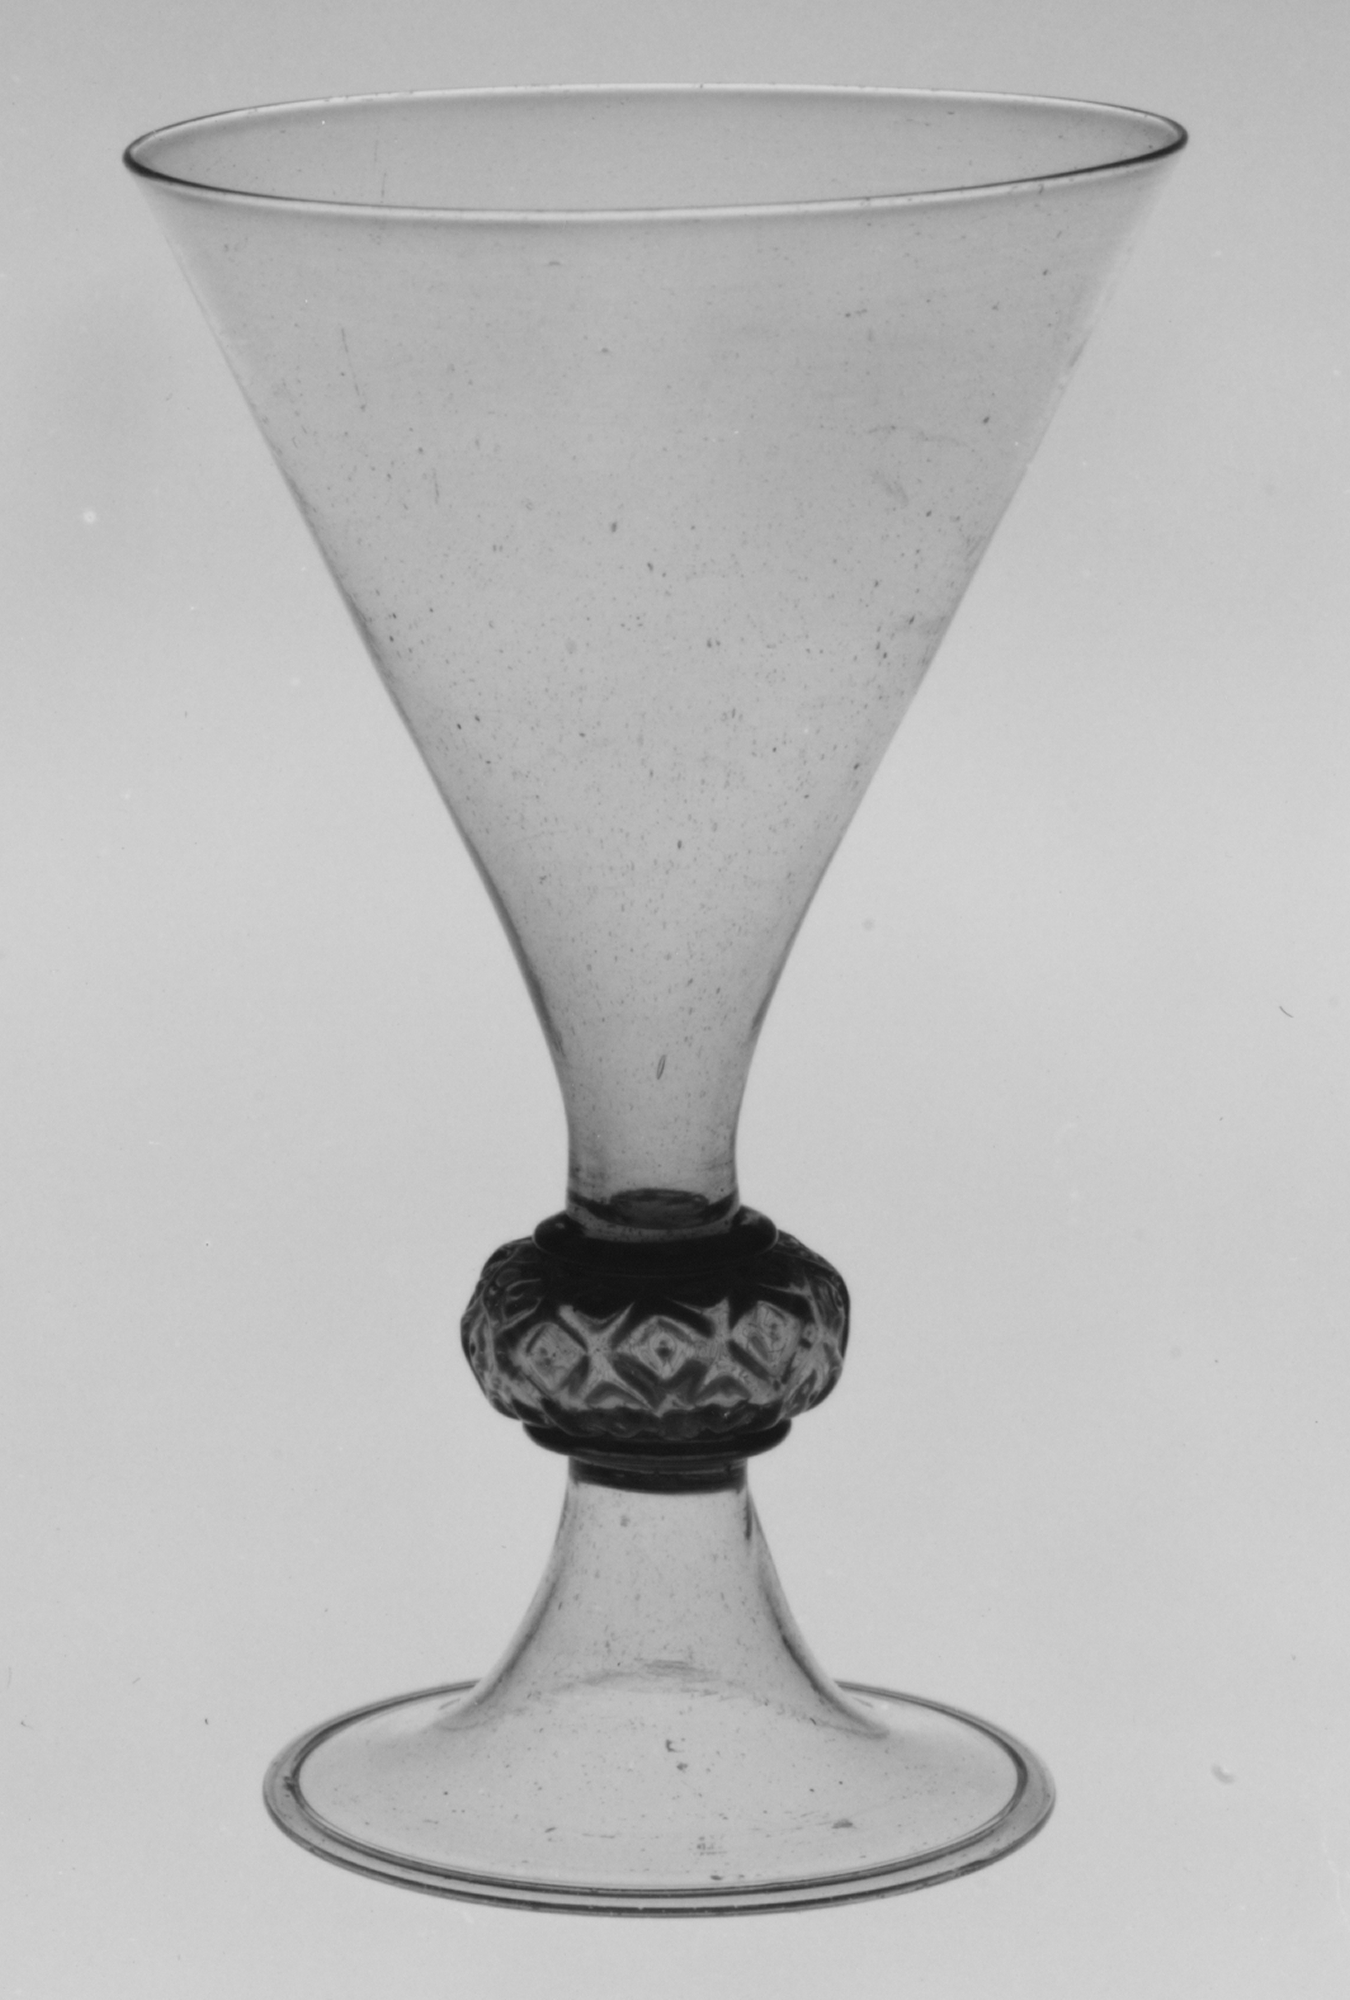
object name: goblet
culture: venetian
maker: tyrol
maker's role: artist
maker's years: 1592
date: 1501-1600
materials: gilt, glass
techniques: glassblowing, molding